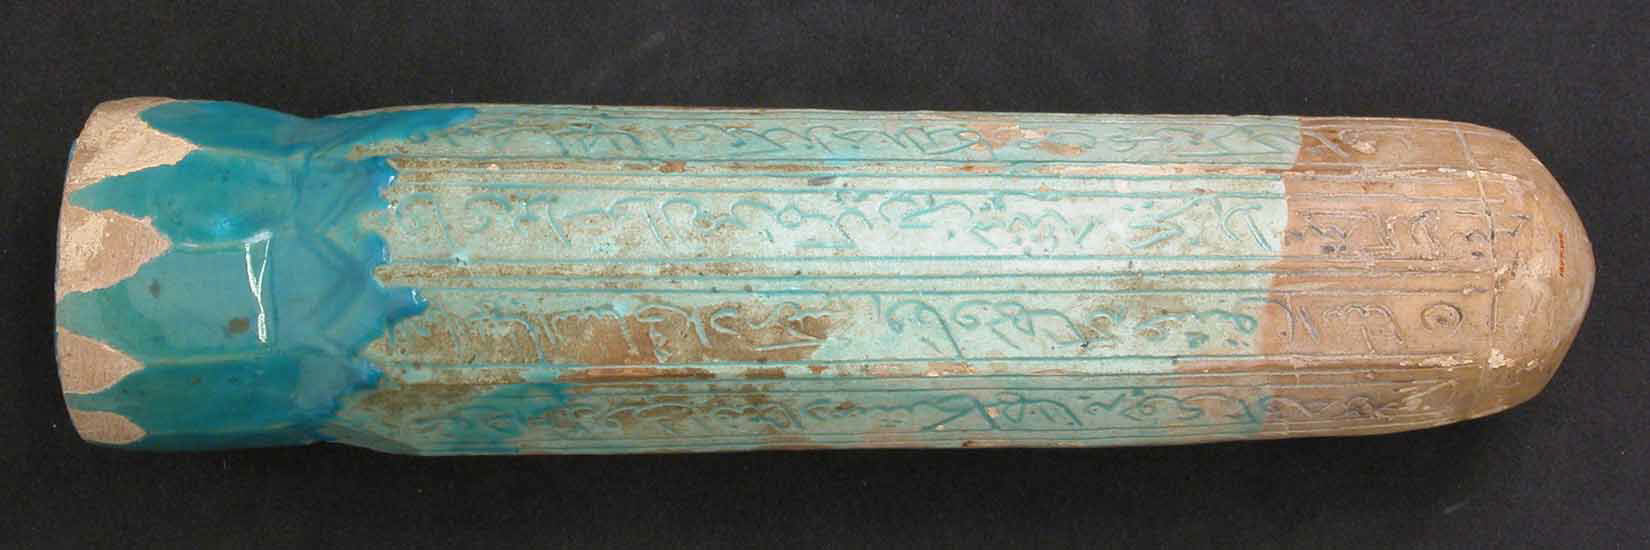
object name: bottle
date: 1401-1433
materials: earthenware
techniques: glazing, incising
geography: iran